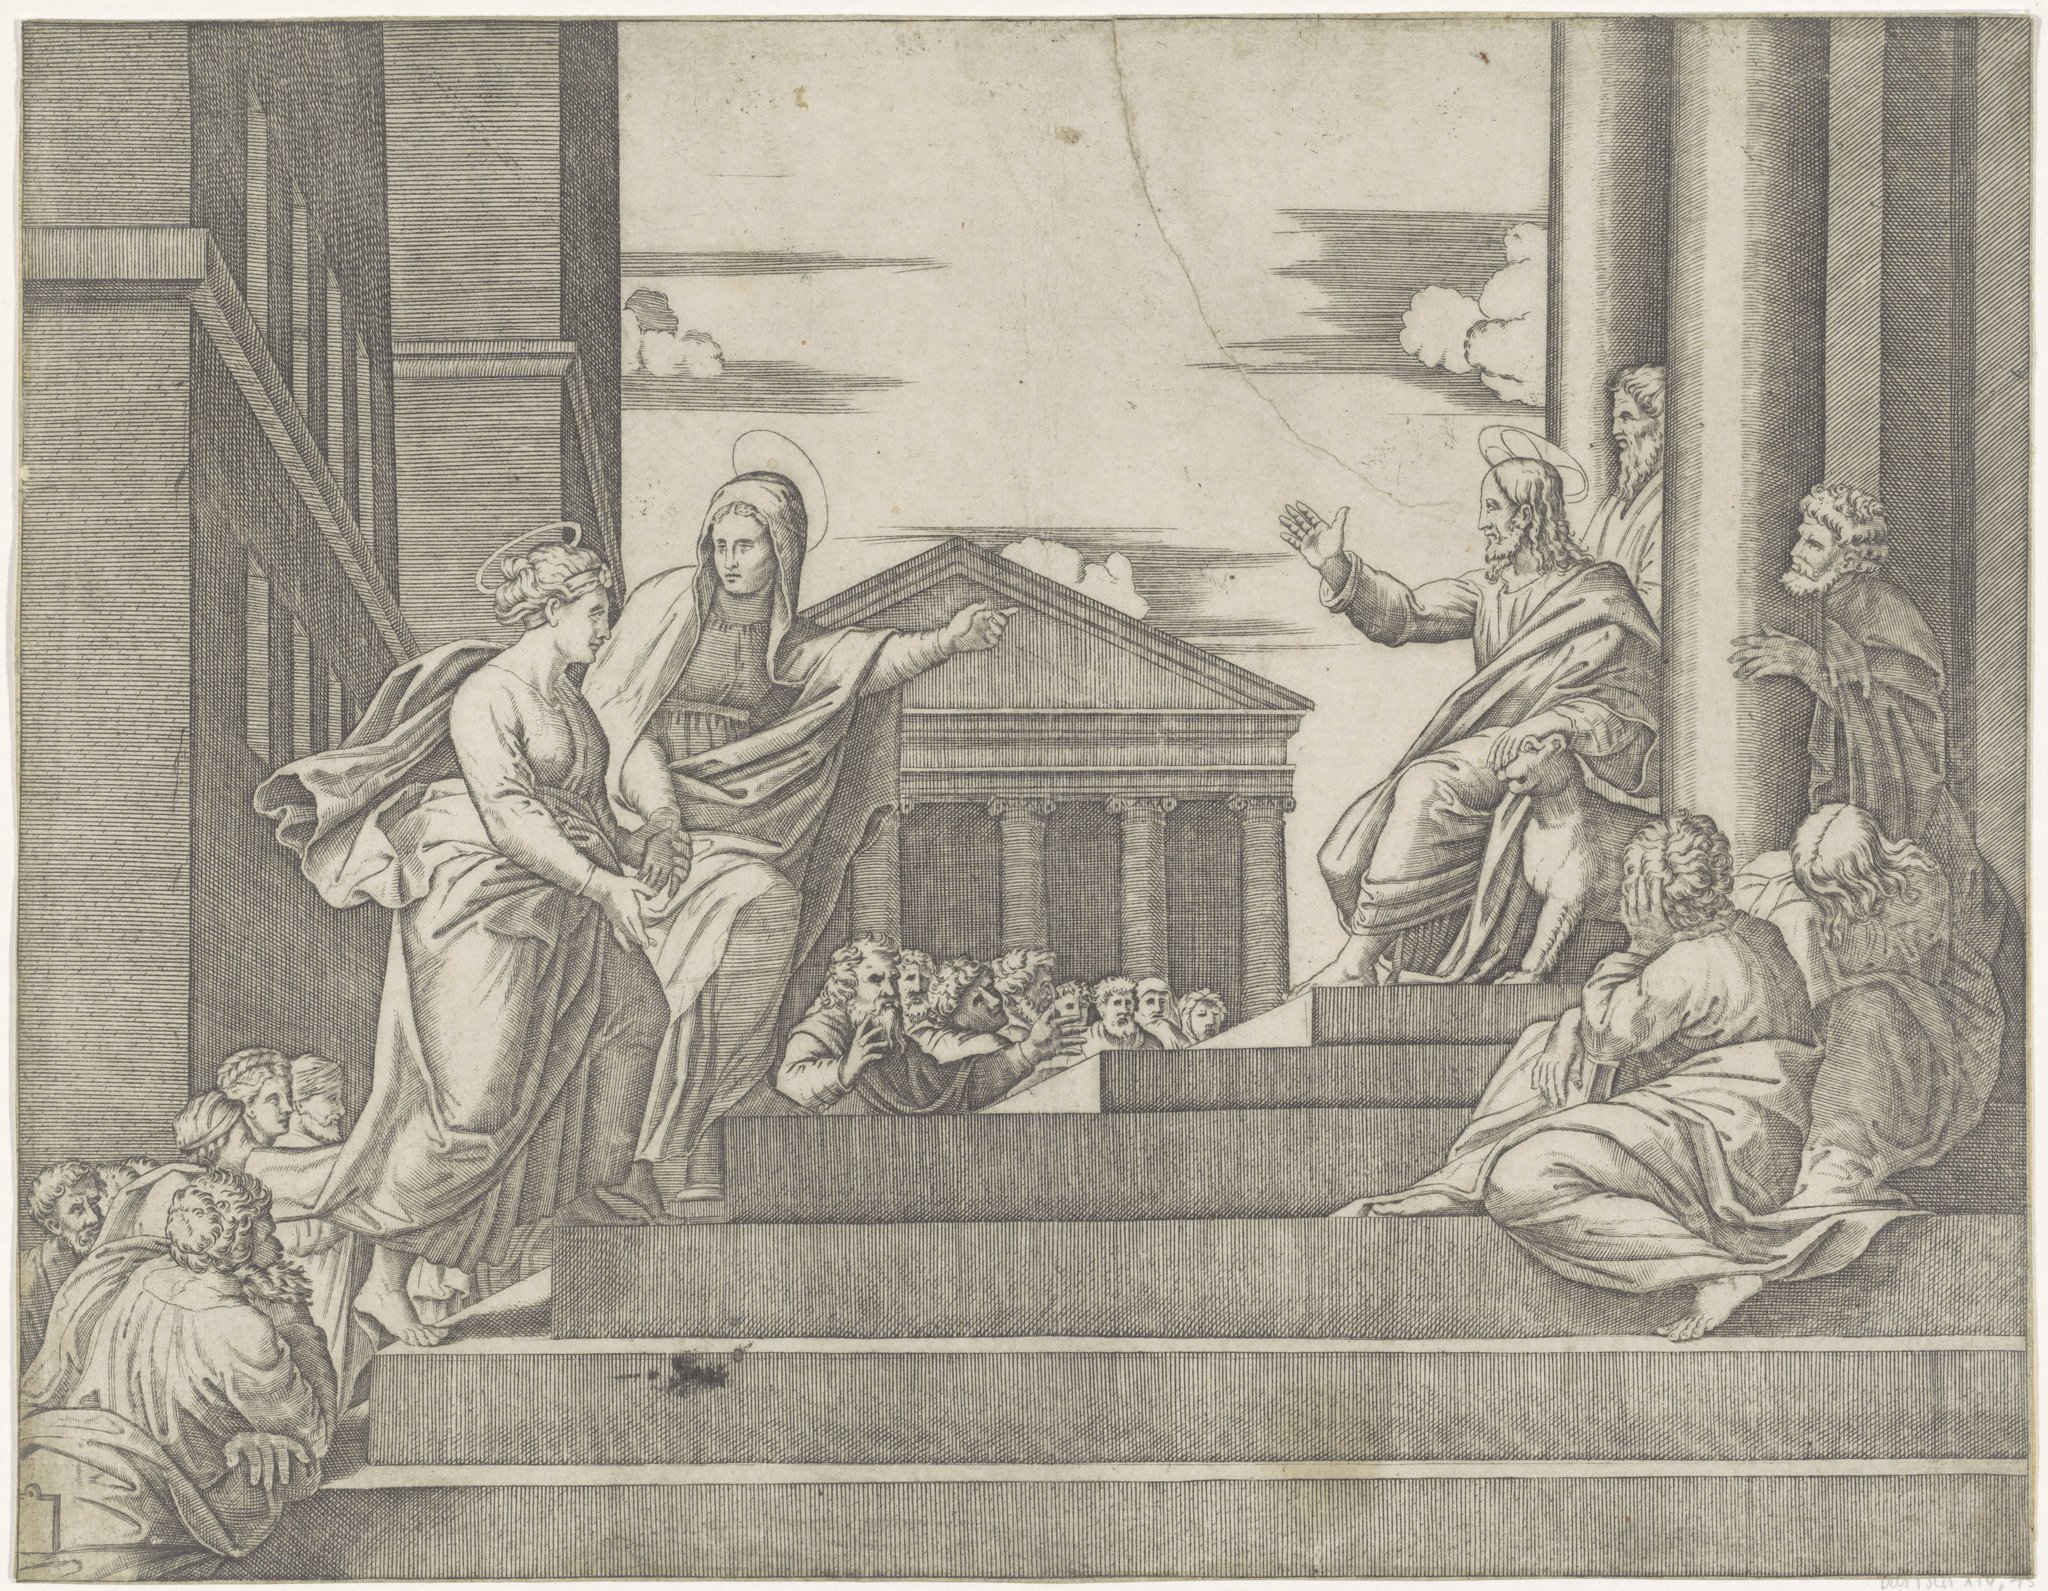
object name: print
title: Marta leidt Maria Magdalena naar Christus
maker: Anonymous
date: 1520-1575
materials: paper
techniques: engraving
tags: the patroness of housewives, martha of bethany; possible attributes: aspergillum, broom, bunch of keys, dragon, ladle, the conversion of st. mary magdalene on hearing christ preaching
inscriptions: collector's mark: Lugt 10, collector's mark: Lugt 11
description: Kopie naar prent van Marcantonio Raimondi. Raimondi baseerde zich op een ontwerp van Giulio Romano voor een niet bewaard gebleven fresco in de S. Trinità dei Monti, Rome (Shoemaker 1981, p. 172).